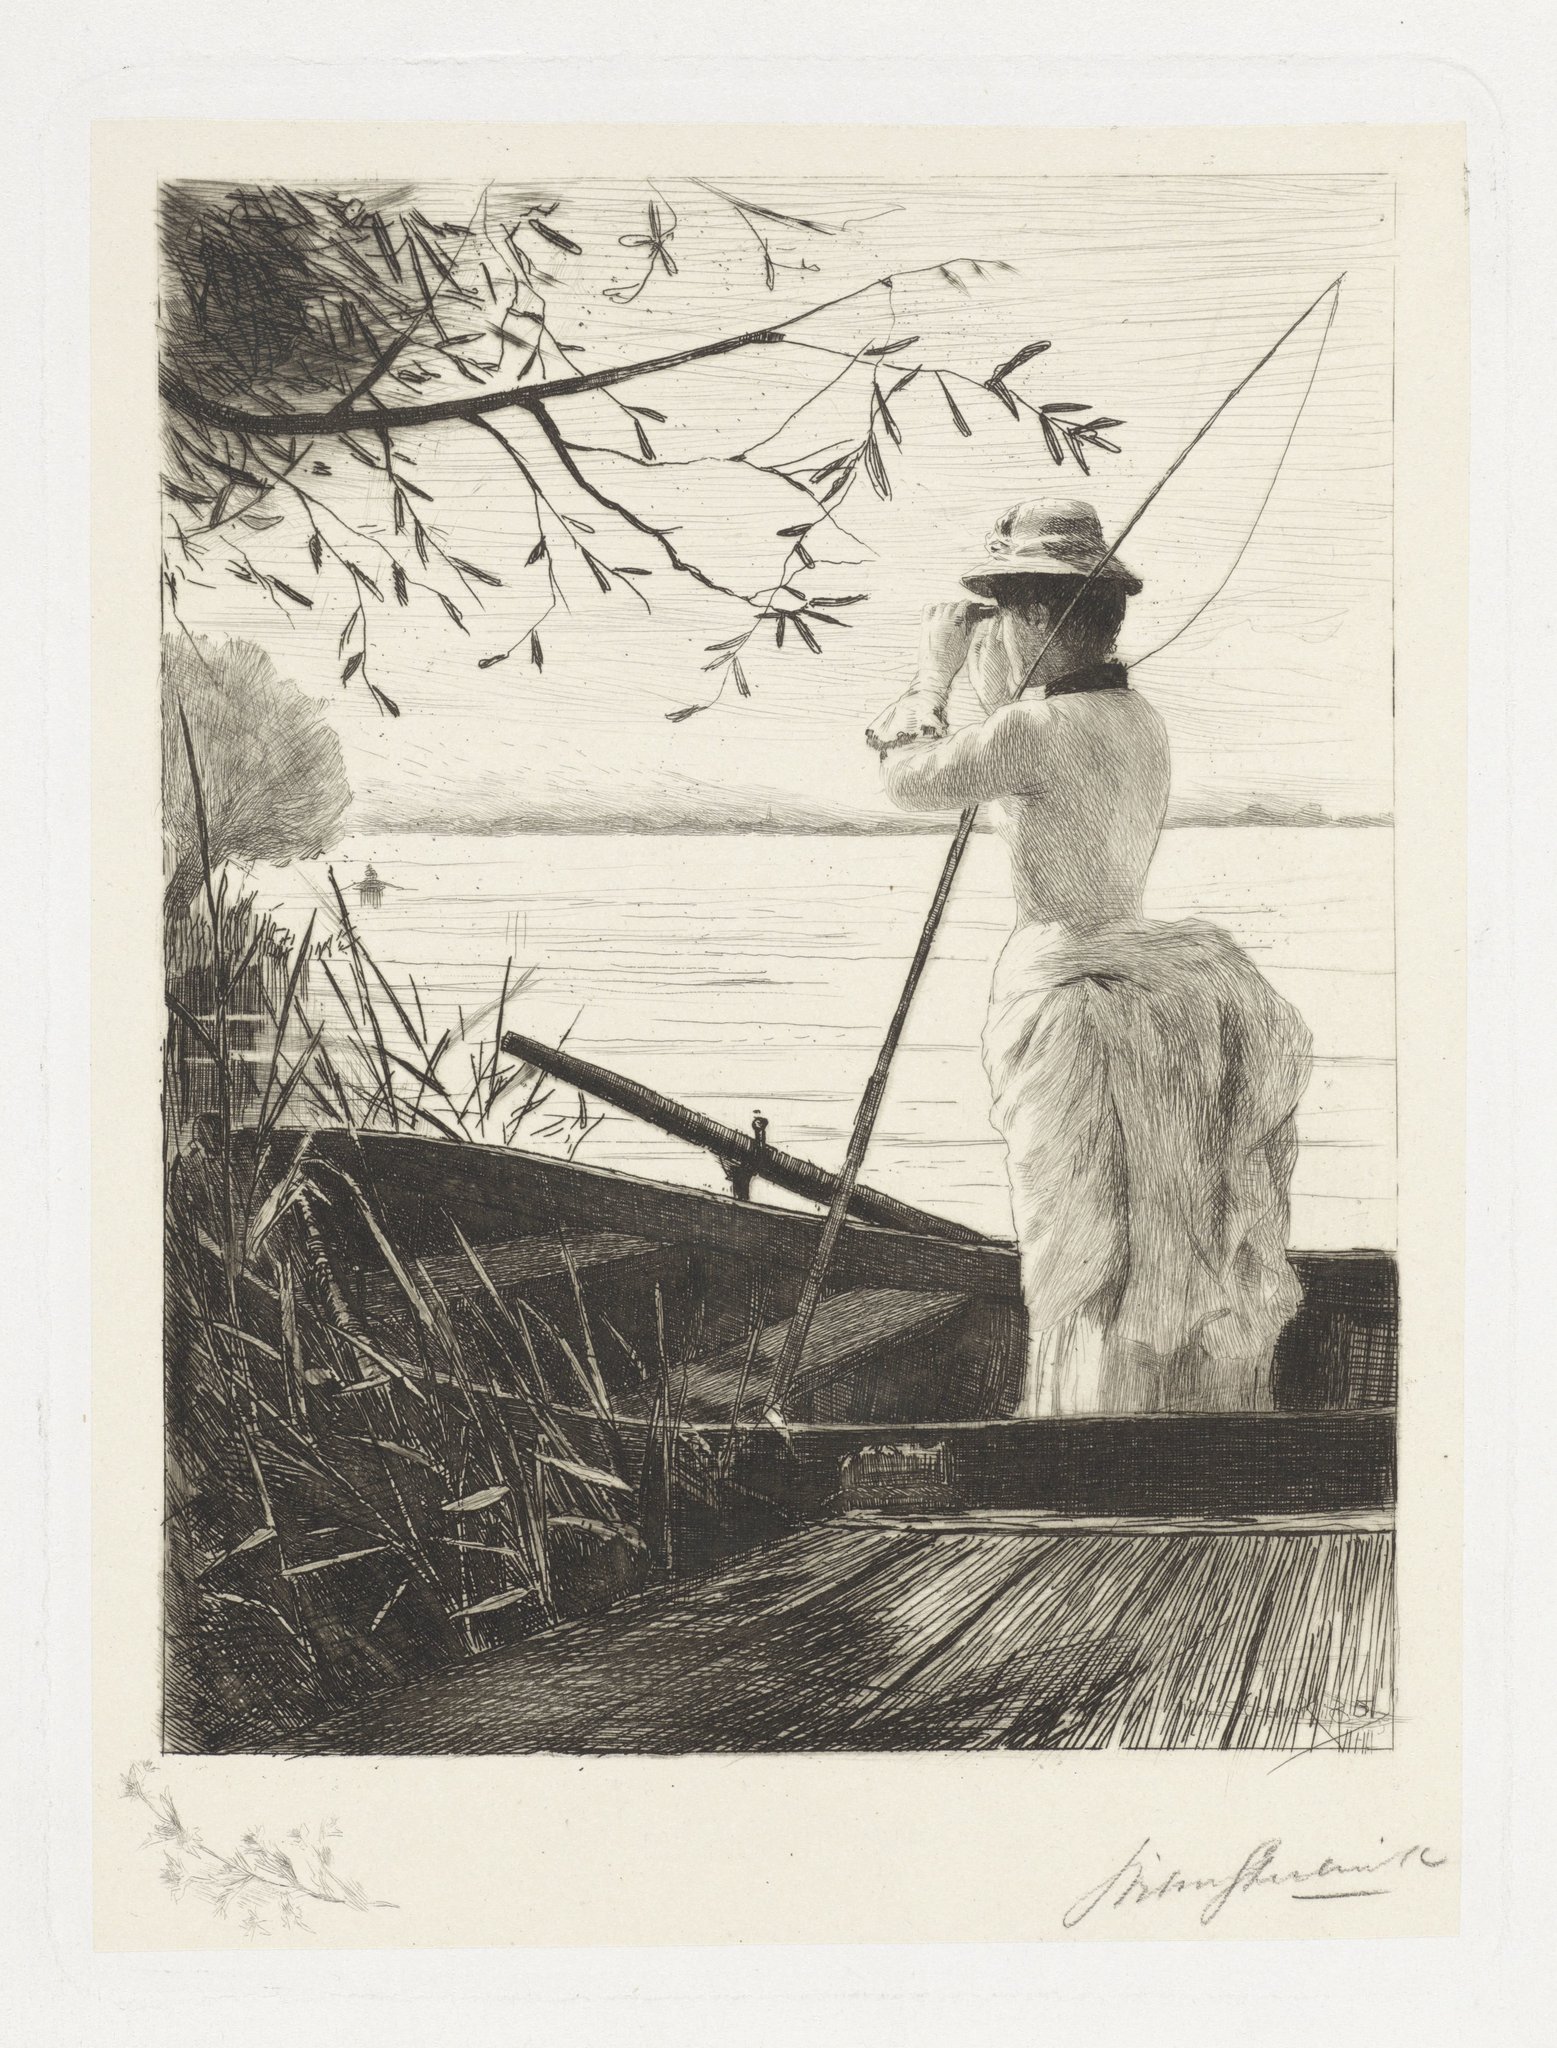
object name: print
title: Vrouw op de uitkijk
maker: willem steelink (ii)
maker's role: draughtsman, print maker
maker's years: 1856-1928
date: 1885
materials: paper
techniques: etching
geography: amsterdam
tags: rowing-boat, canoe, etc., binoculars, spy-glass, etc.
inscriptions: collector's mark: Lugt 2228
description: Een vrouw staat in een roeiboot met een vishengel over de schouder en tuurt door een verrekijker naar een roeiboot. Linksonder in de marge het takje van een distel.